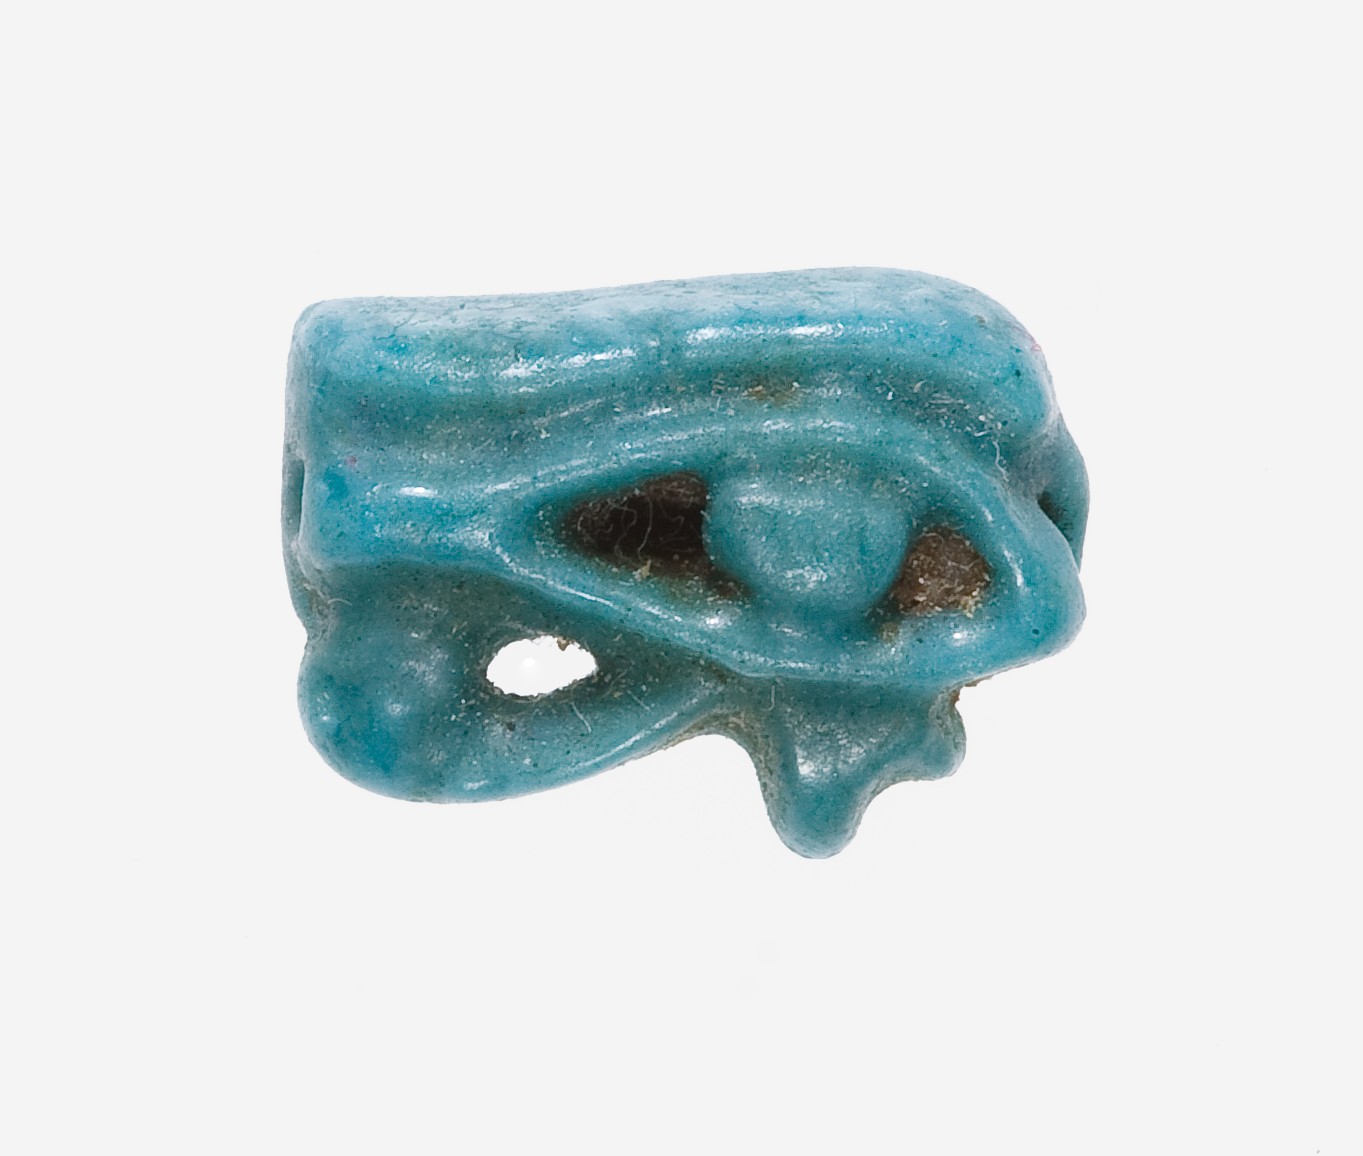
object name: amulet, wedjat eye, nefer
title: Sacred Eye Amulet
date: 1390-1352 BCE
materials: faience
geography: egypt